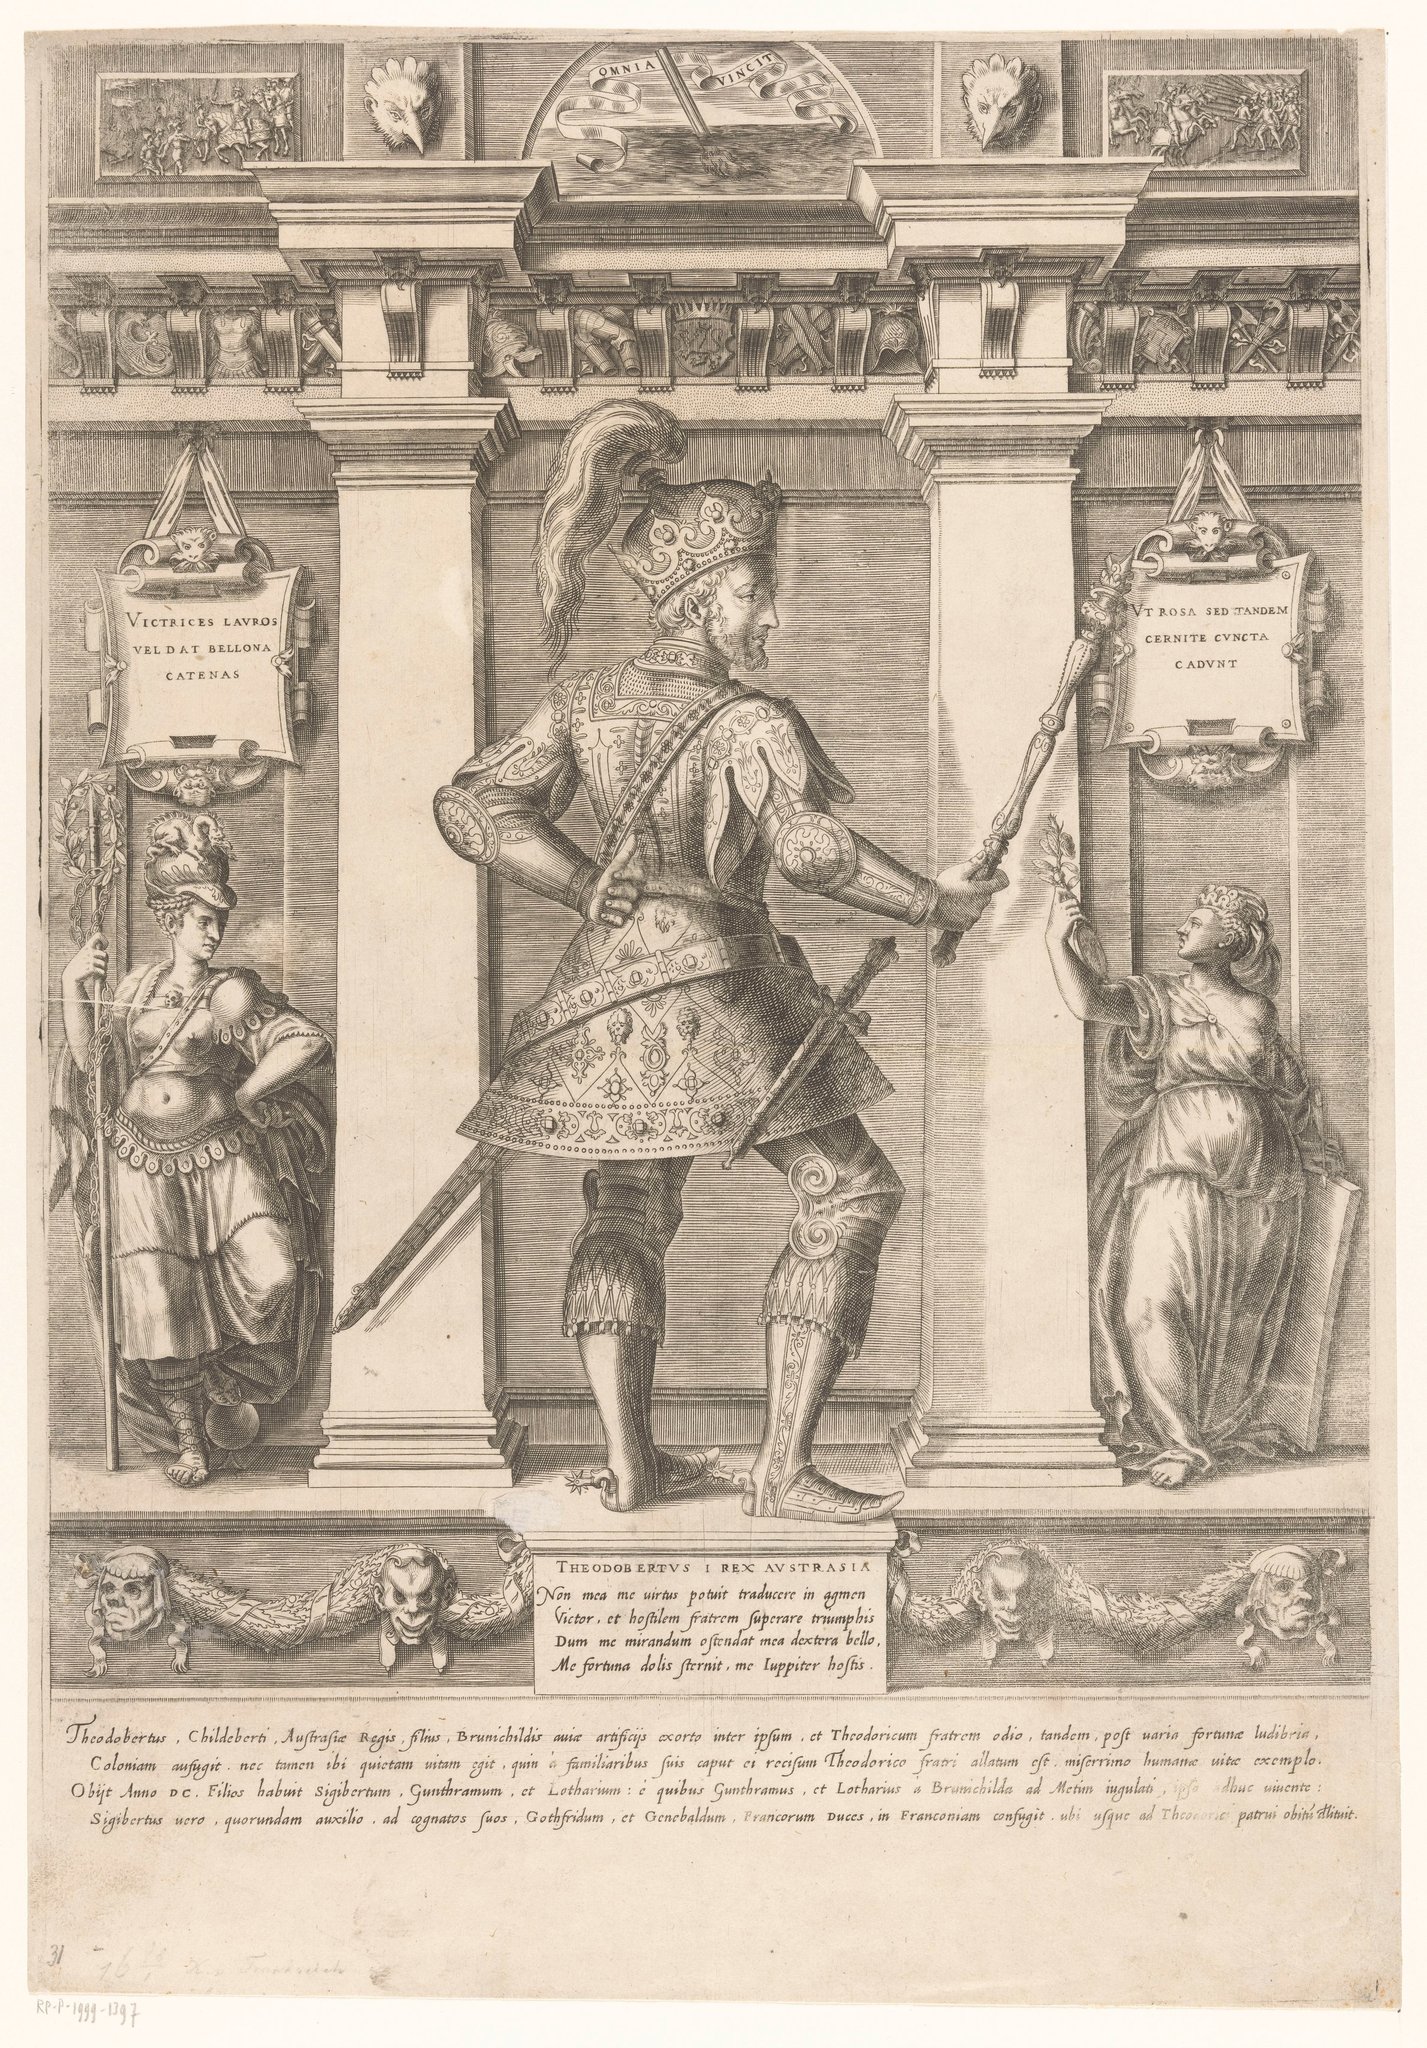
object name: print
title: Portret van Theodobertus I, koning van Oostenrijk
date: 1569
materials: paper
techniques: engraving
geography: italy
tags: historical persons, ruler, sovereign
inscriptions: collector's mark: Lugt 2228, collector's mark: Lugt 2760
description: Deze prent maakt deel uit van een reeks van 58 prenten. Het meerendeel van de prenten bevat portretten van 74 leden van het Oostenrijkse Huis, naar tekeningen door Francesco Terzio, die deels getekend zijn naar de 28 levensgrote bronzen beelden die rond de cenotaaf van Maximiliaan I in de Hofkirche te Innsbruck staan.